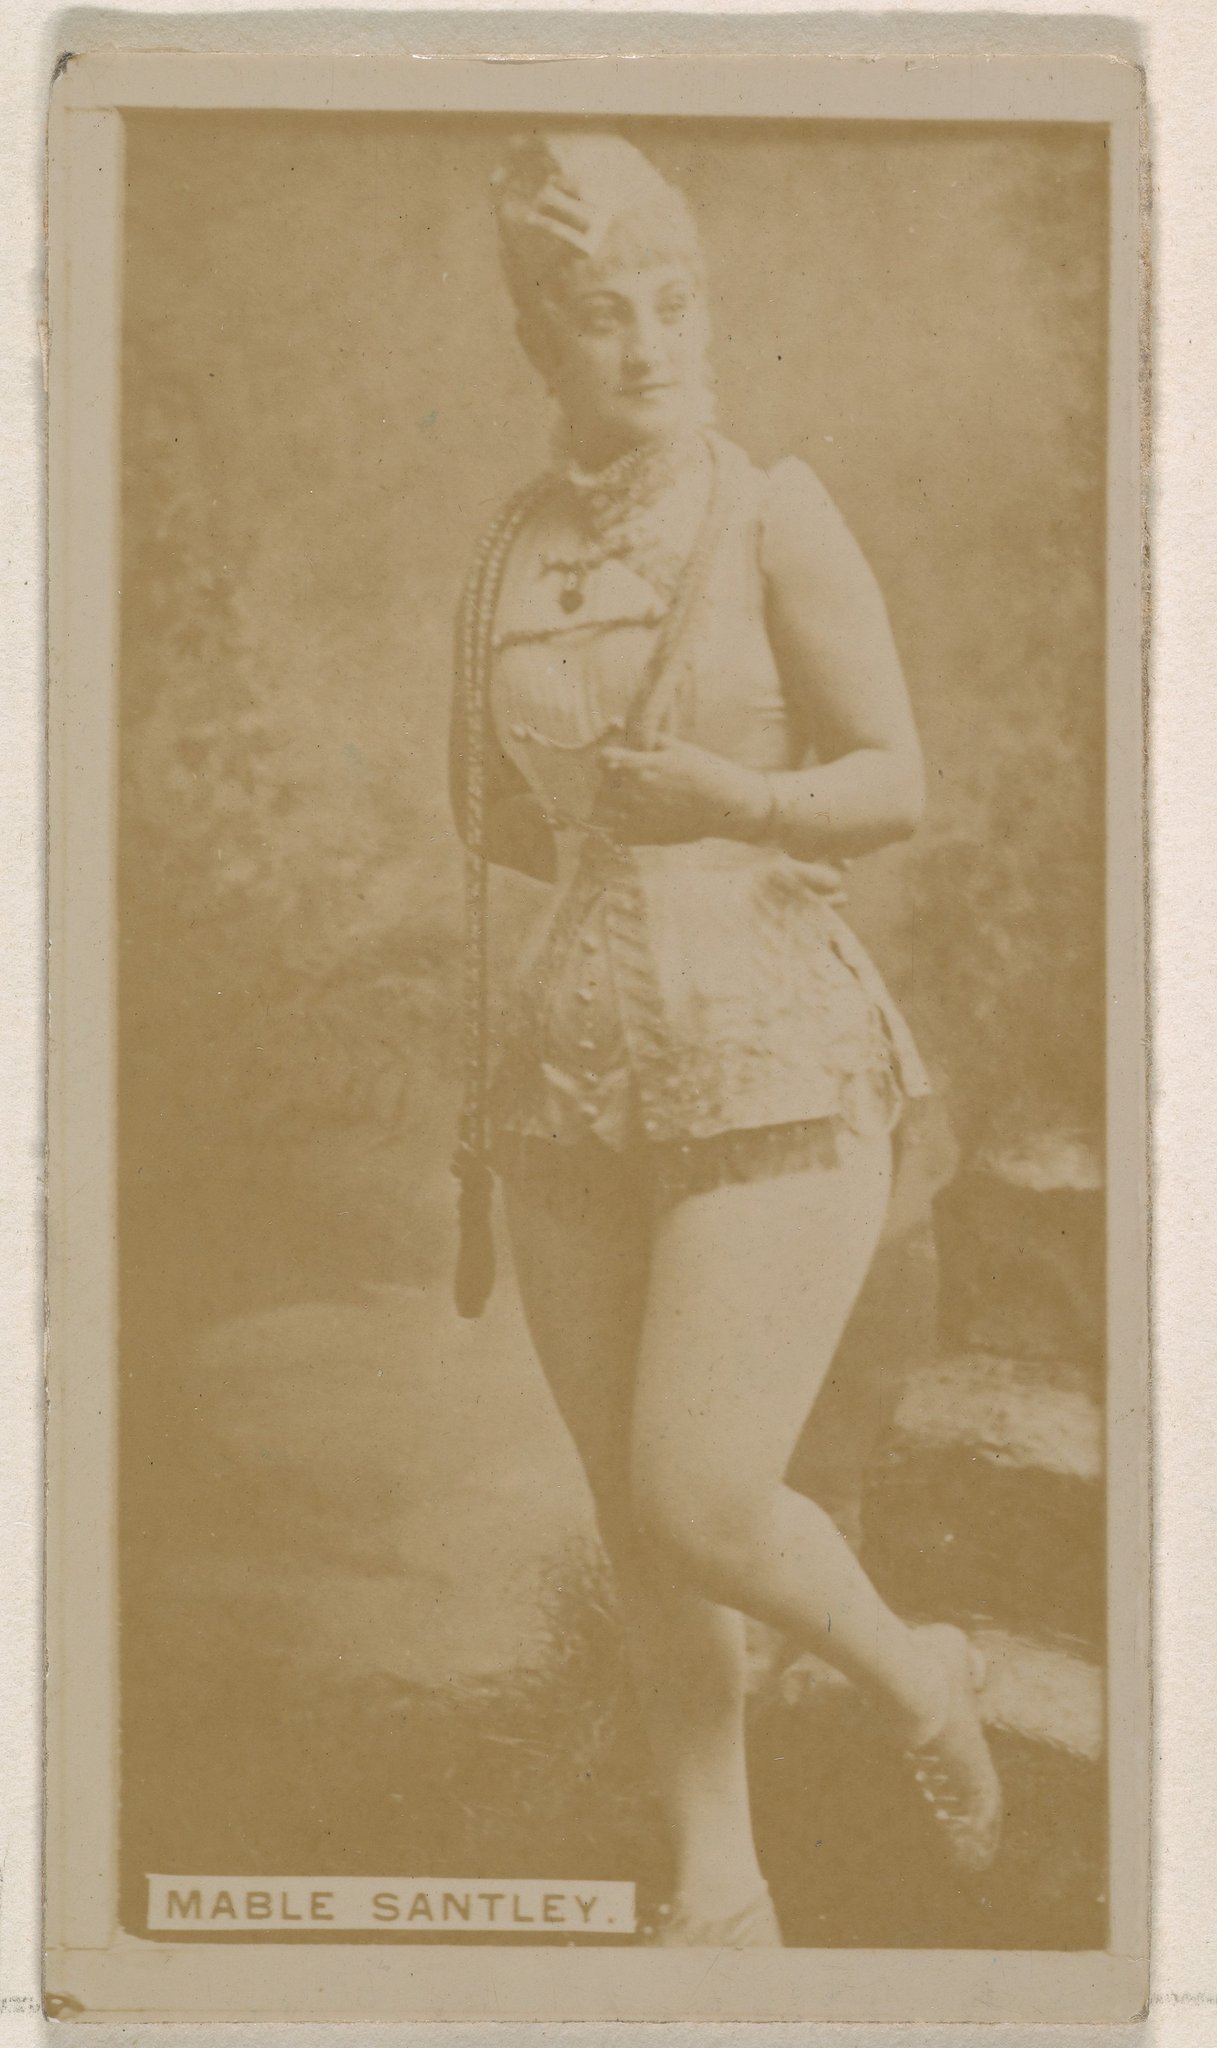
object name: photograph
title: Mabel Santley, from the Actresses series (N245) issued by Kinney Brothers to promote Sweet Caporal Cigarettes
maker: kinney brothers tobacco company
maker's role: publisher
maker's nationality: american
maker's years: 1869-2011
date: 1890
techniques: albumen silver print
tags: portraits,women,actresses